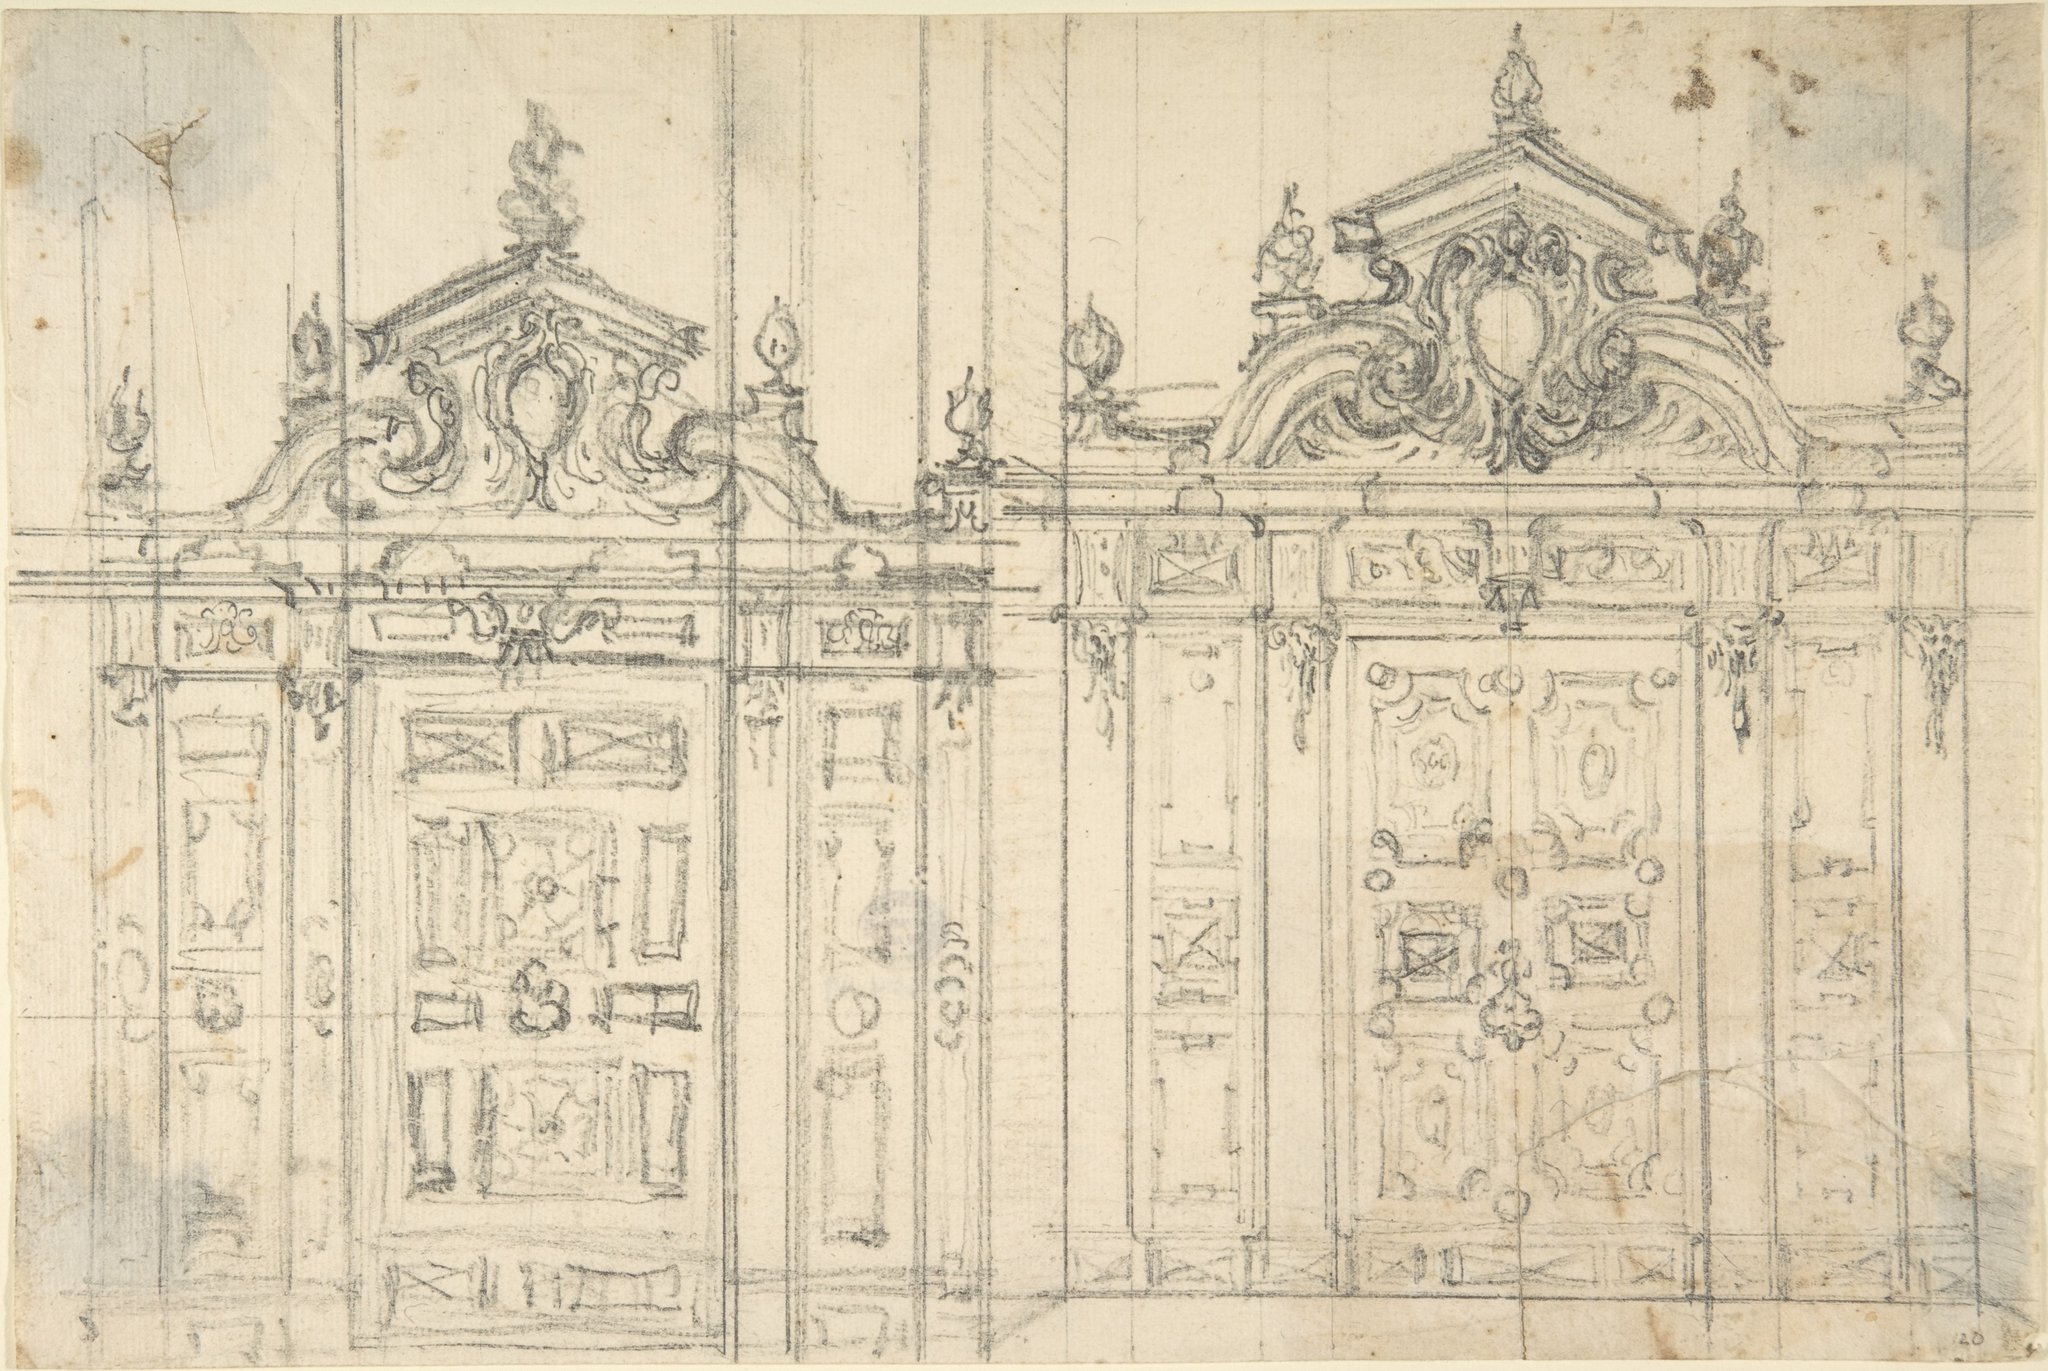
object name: drawing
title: Design for a decoration of wall doors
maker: anonymous, italian, piedmontese, 18th century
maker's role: artist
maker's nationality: italian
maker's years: 1700-1800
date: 1700-1780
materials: graphite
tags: architecture,doors